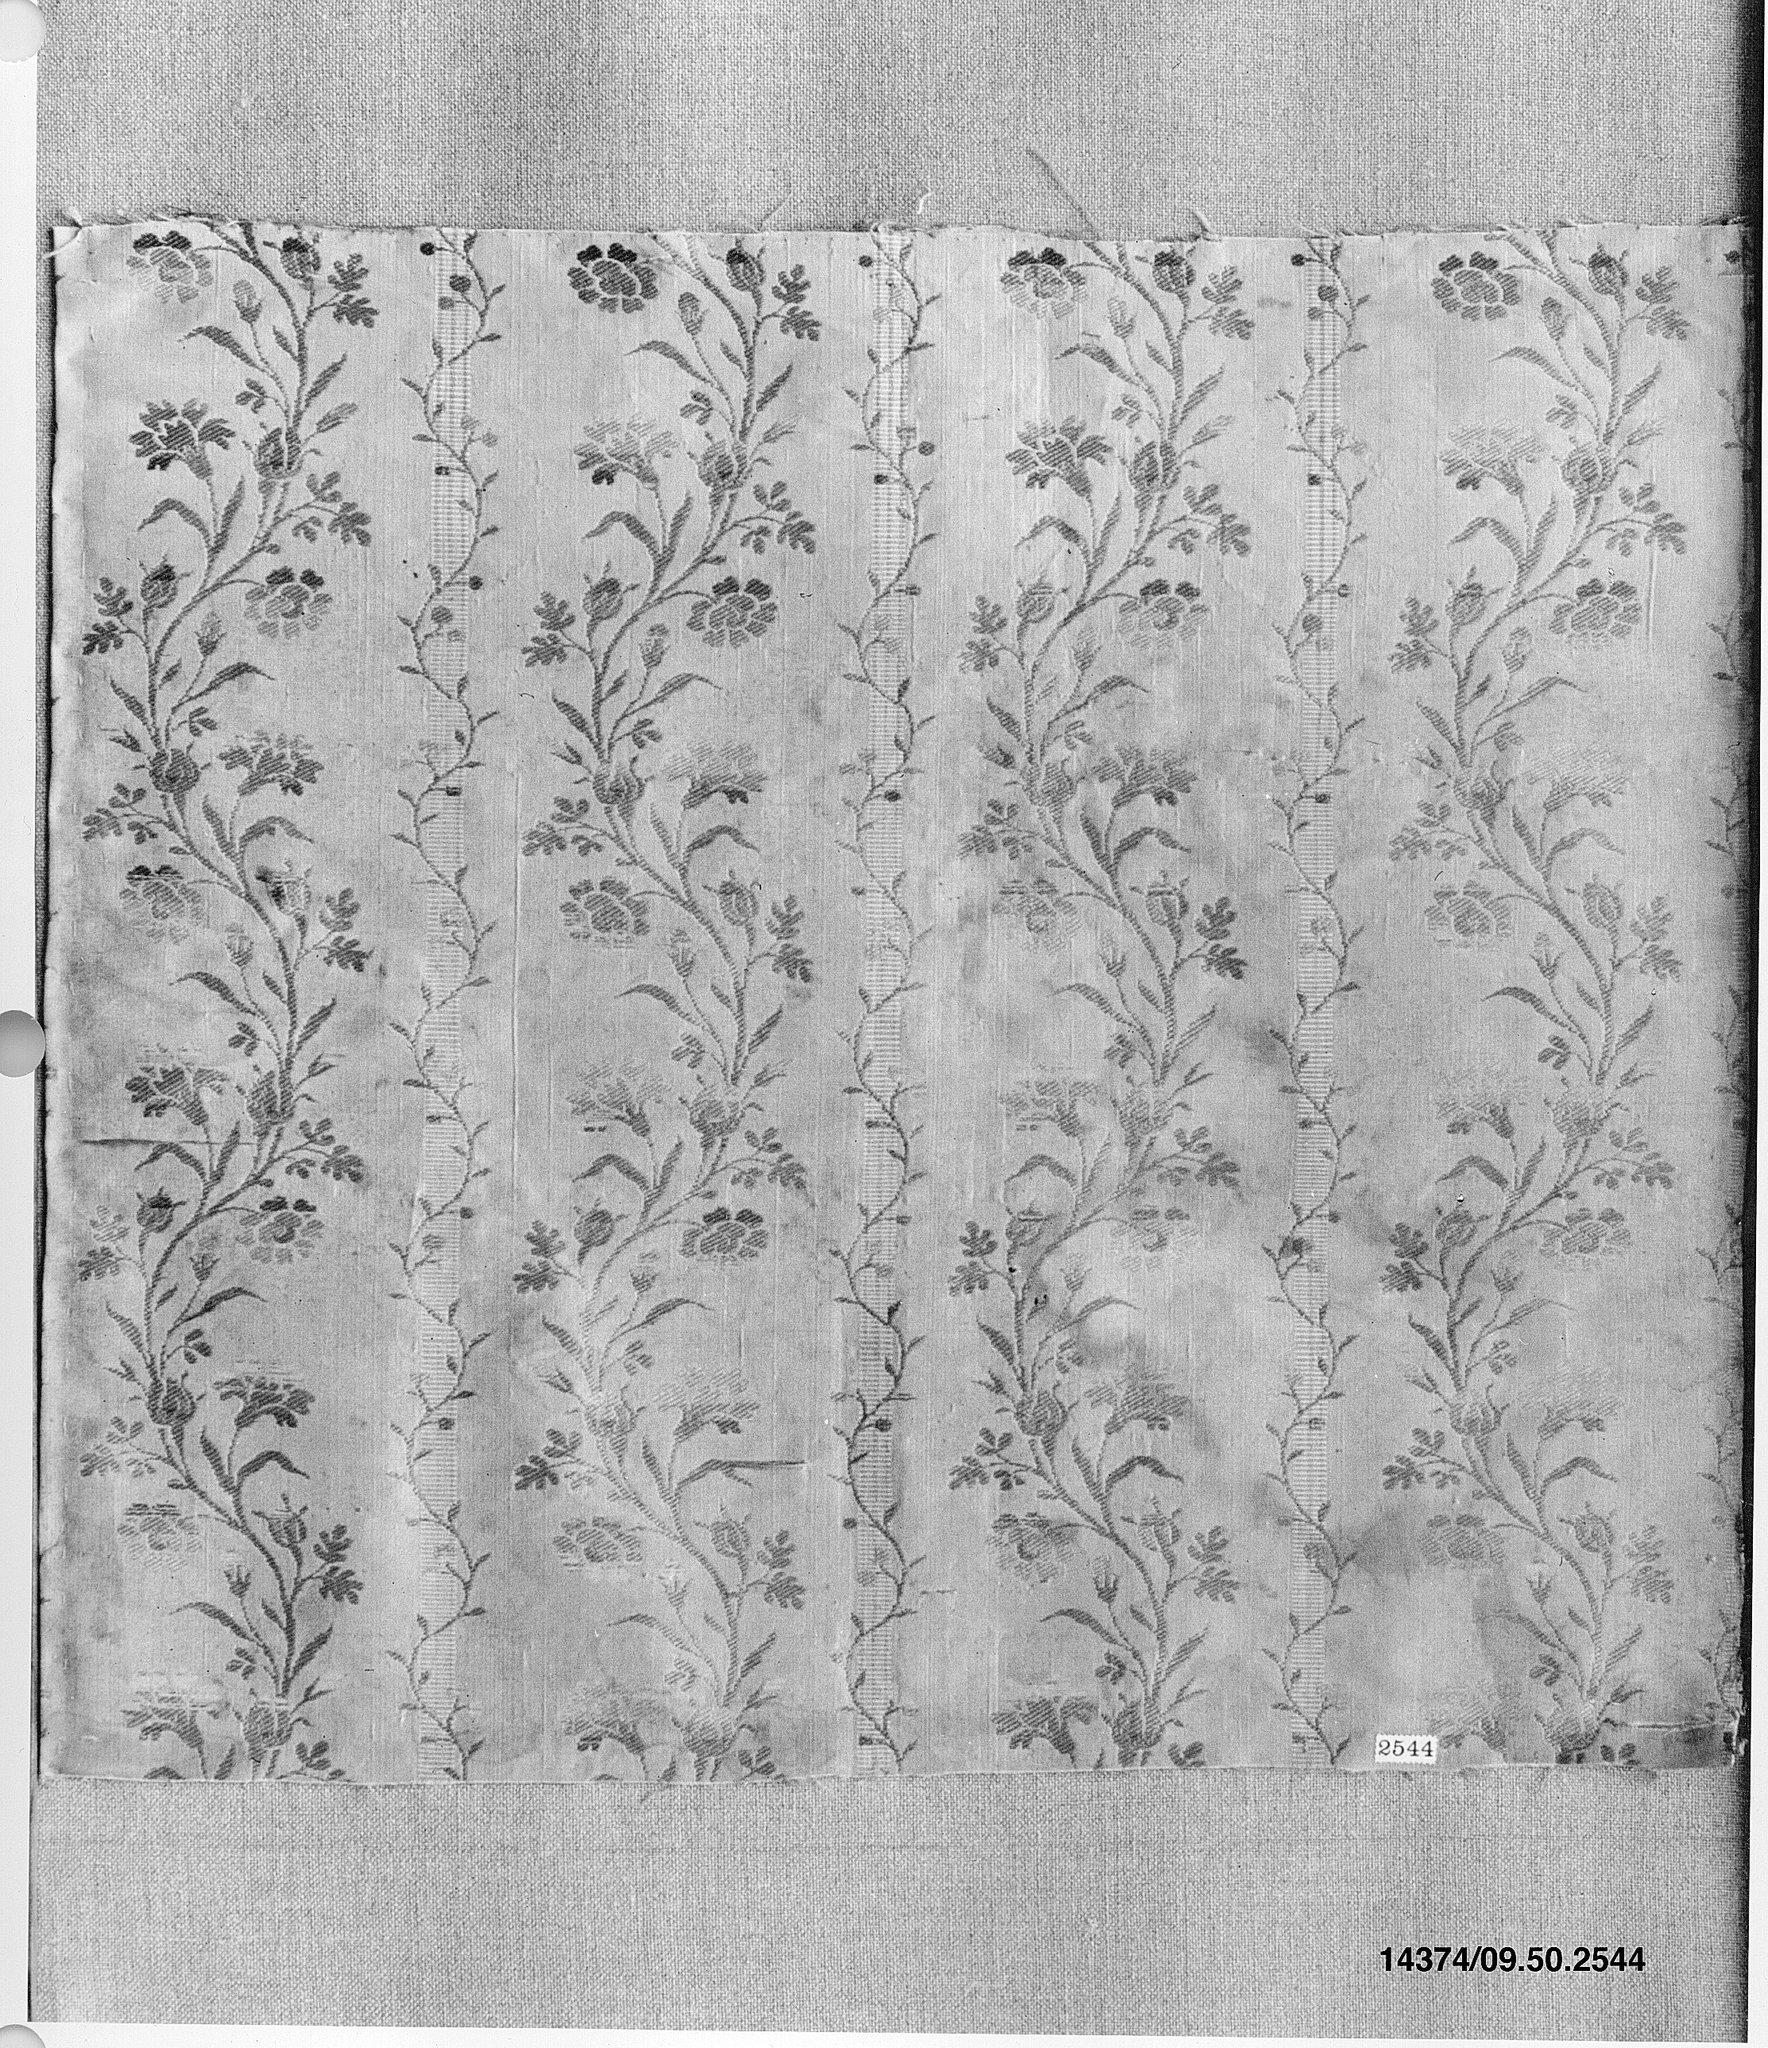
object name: piece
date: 1775-1780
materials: silk